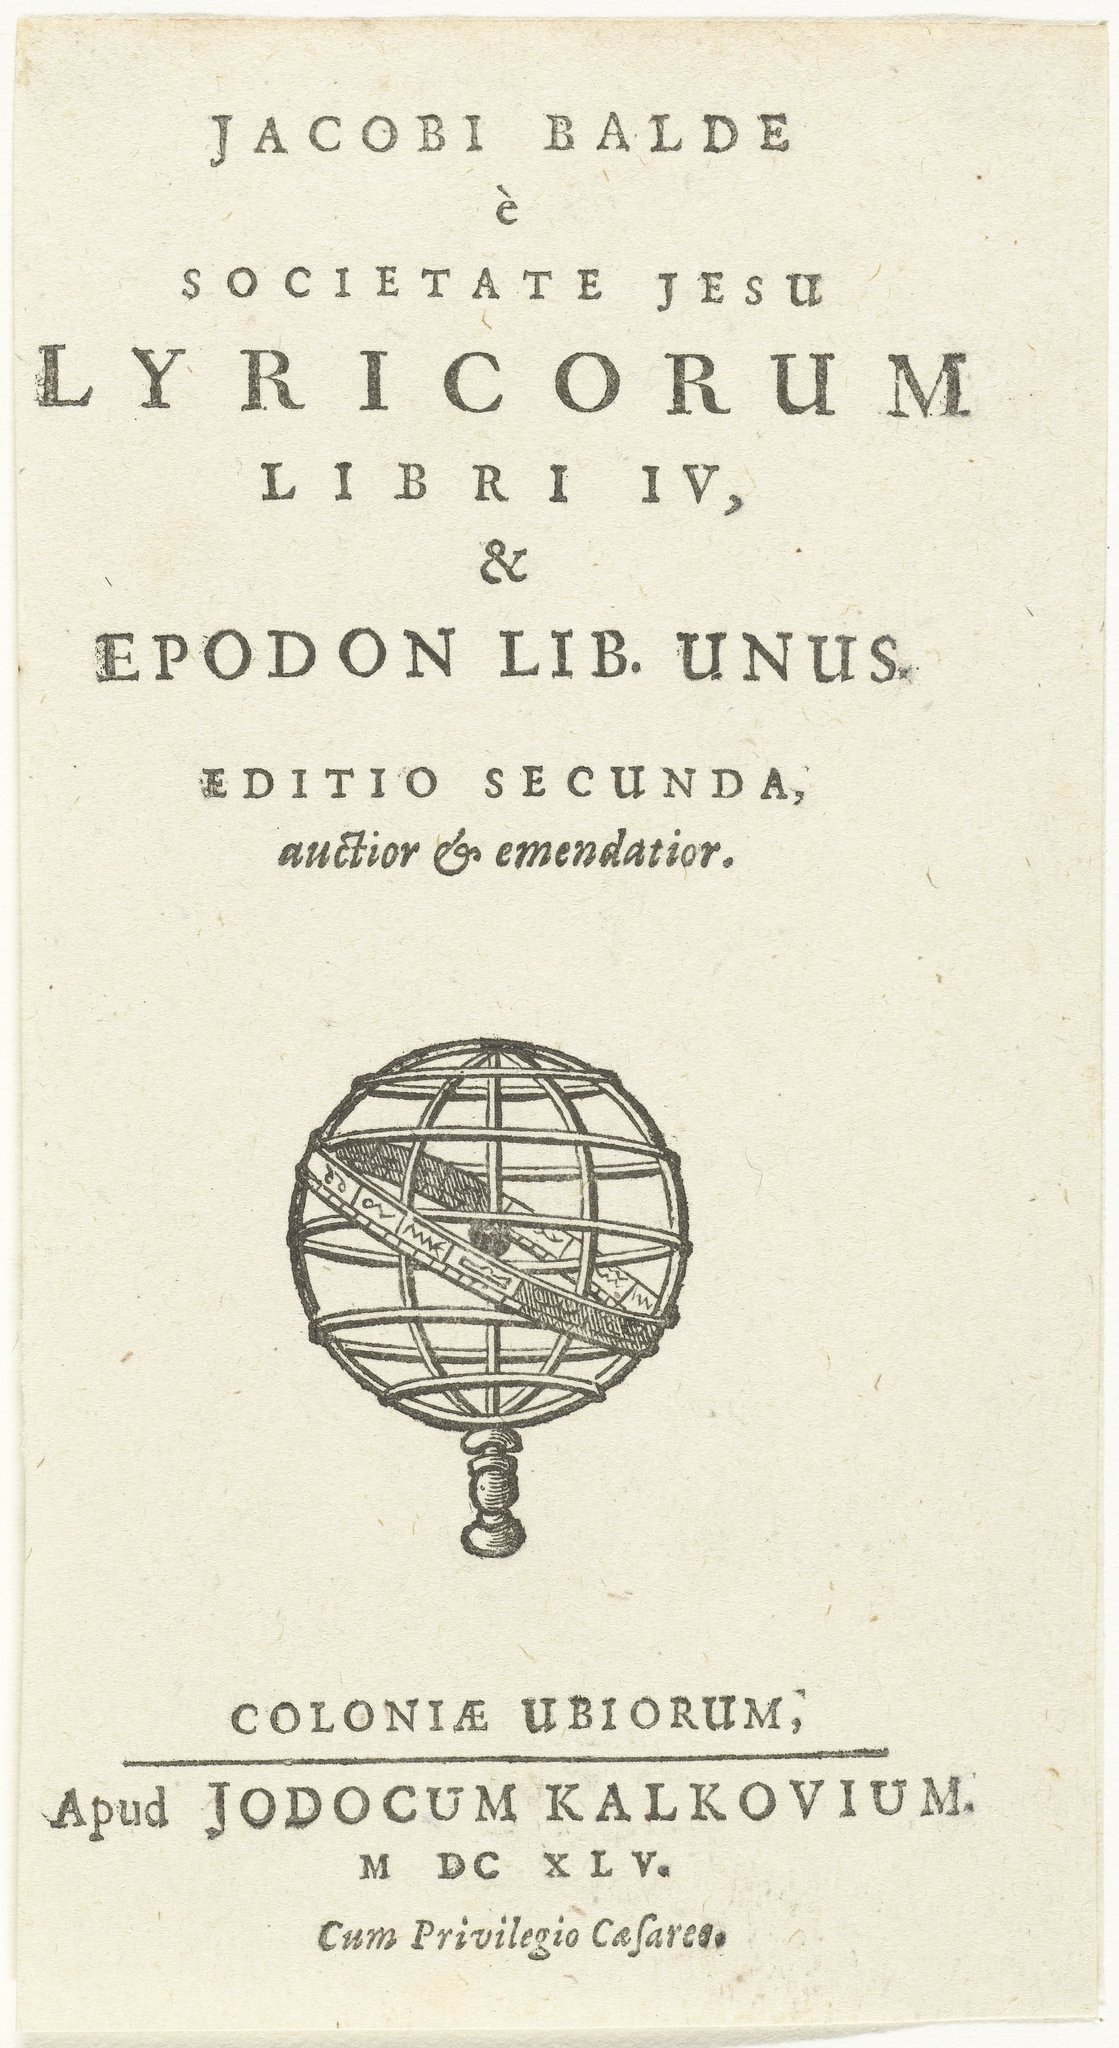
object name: text sheet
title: Titel en armillarium als titelvignet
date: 1645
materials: paper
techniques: engraving, letterpress printing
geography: cologne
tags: armillary sphere, skeleton celestial globe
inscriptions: collector's mark: Lugt 2228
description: Titelpagina voor: Jacobus Balde, Lyricorum libri IV, Lowijs Elzevier (III) (drukker), Jost Kalckhoven (uitgever), Keulen 1645